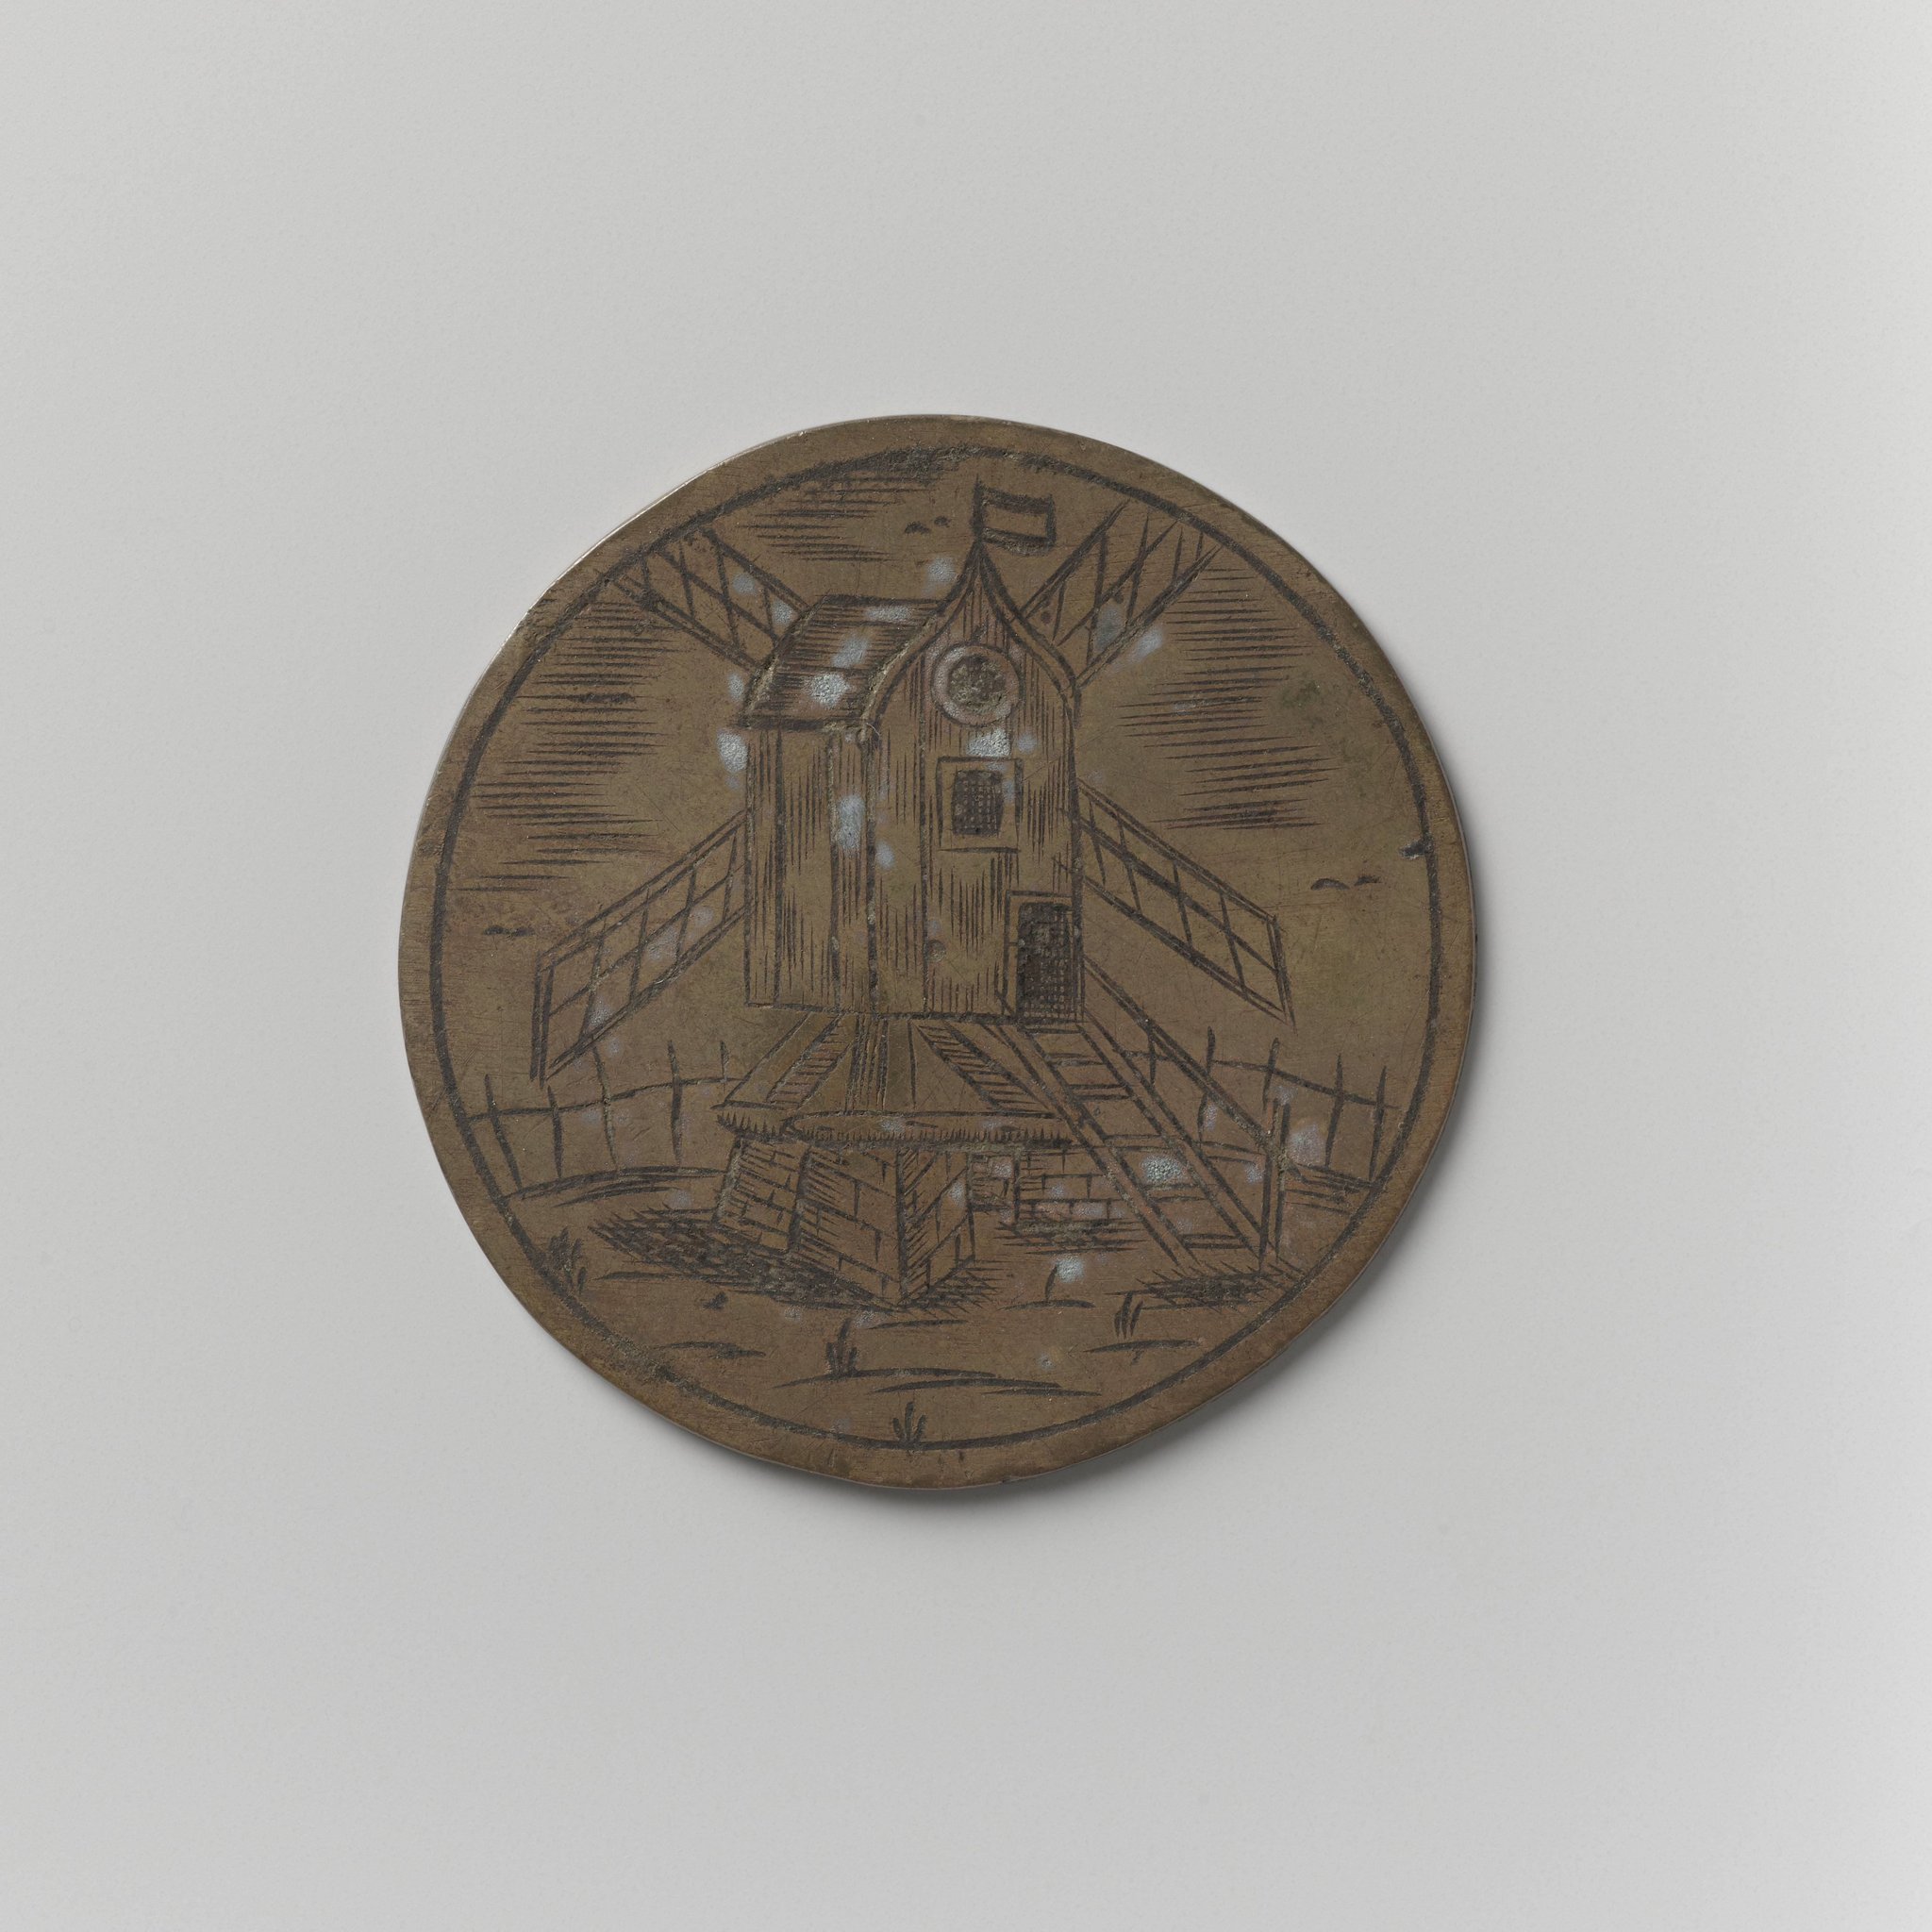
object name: medal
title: Korenmolenaarsgilde van Amsterdam, gildepenning van J. van der Craats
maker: Anonymous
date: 1827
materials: copper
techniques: engraving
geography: amsterdam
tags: amsterdam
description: Koperen penning. Voorzijde: korenmolen met vlag in top. Keerzijde: opschrift